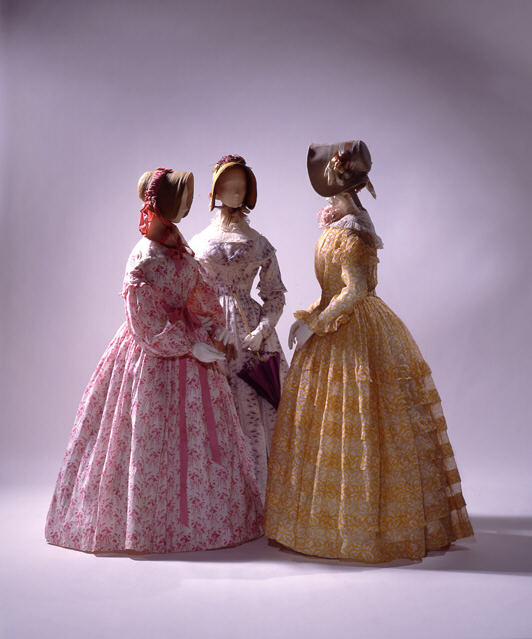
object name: dress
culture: american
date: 1844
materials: cotton